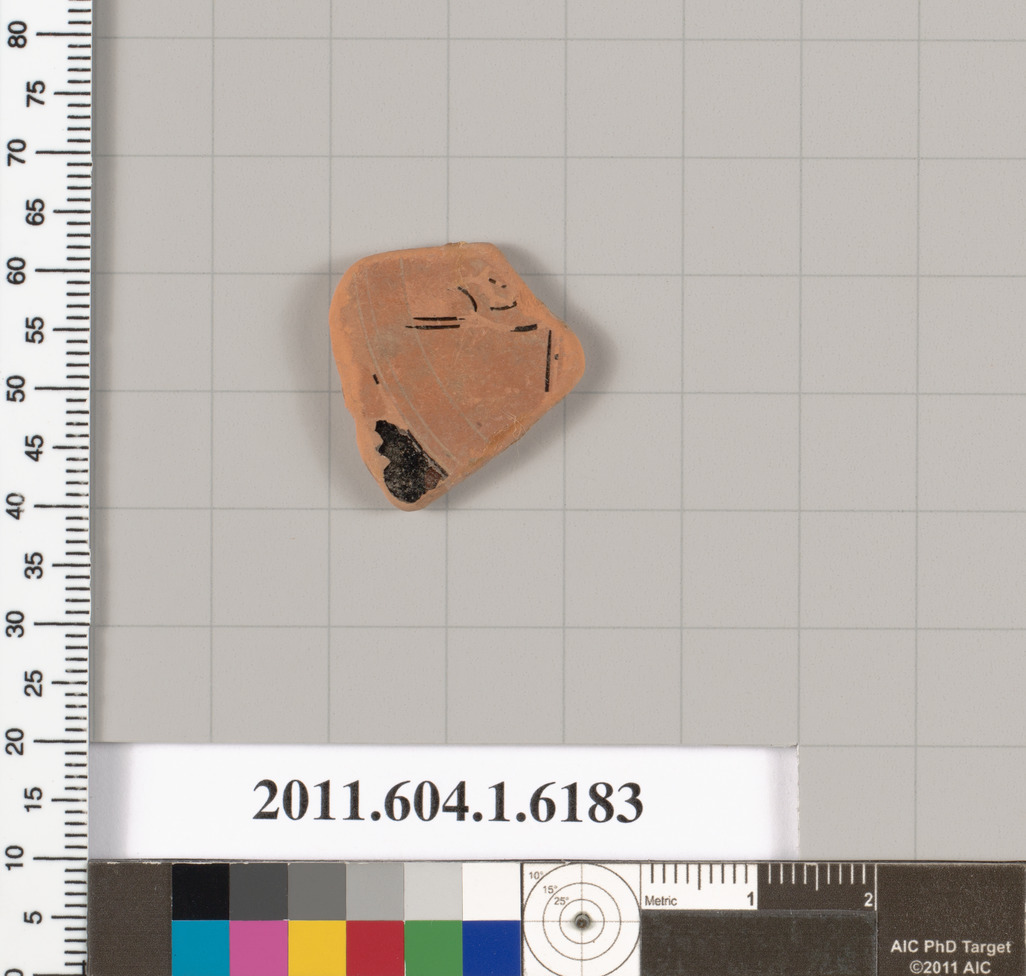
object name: kylix fragment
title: Terracotta fragment of a kylix (drinking cup)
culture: greek, attic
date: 520-500 BCE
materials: terracotta